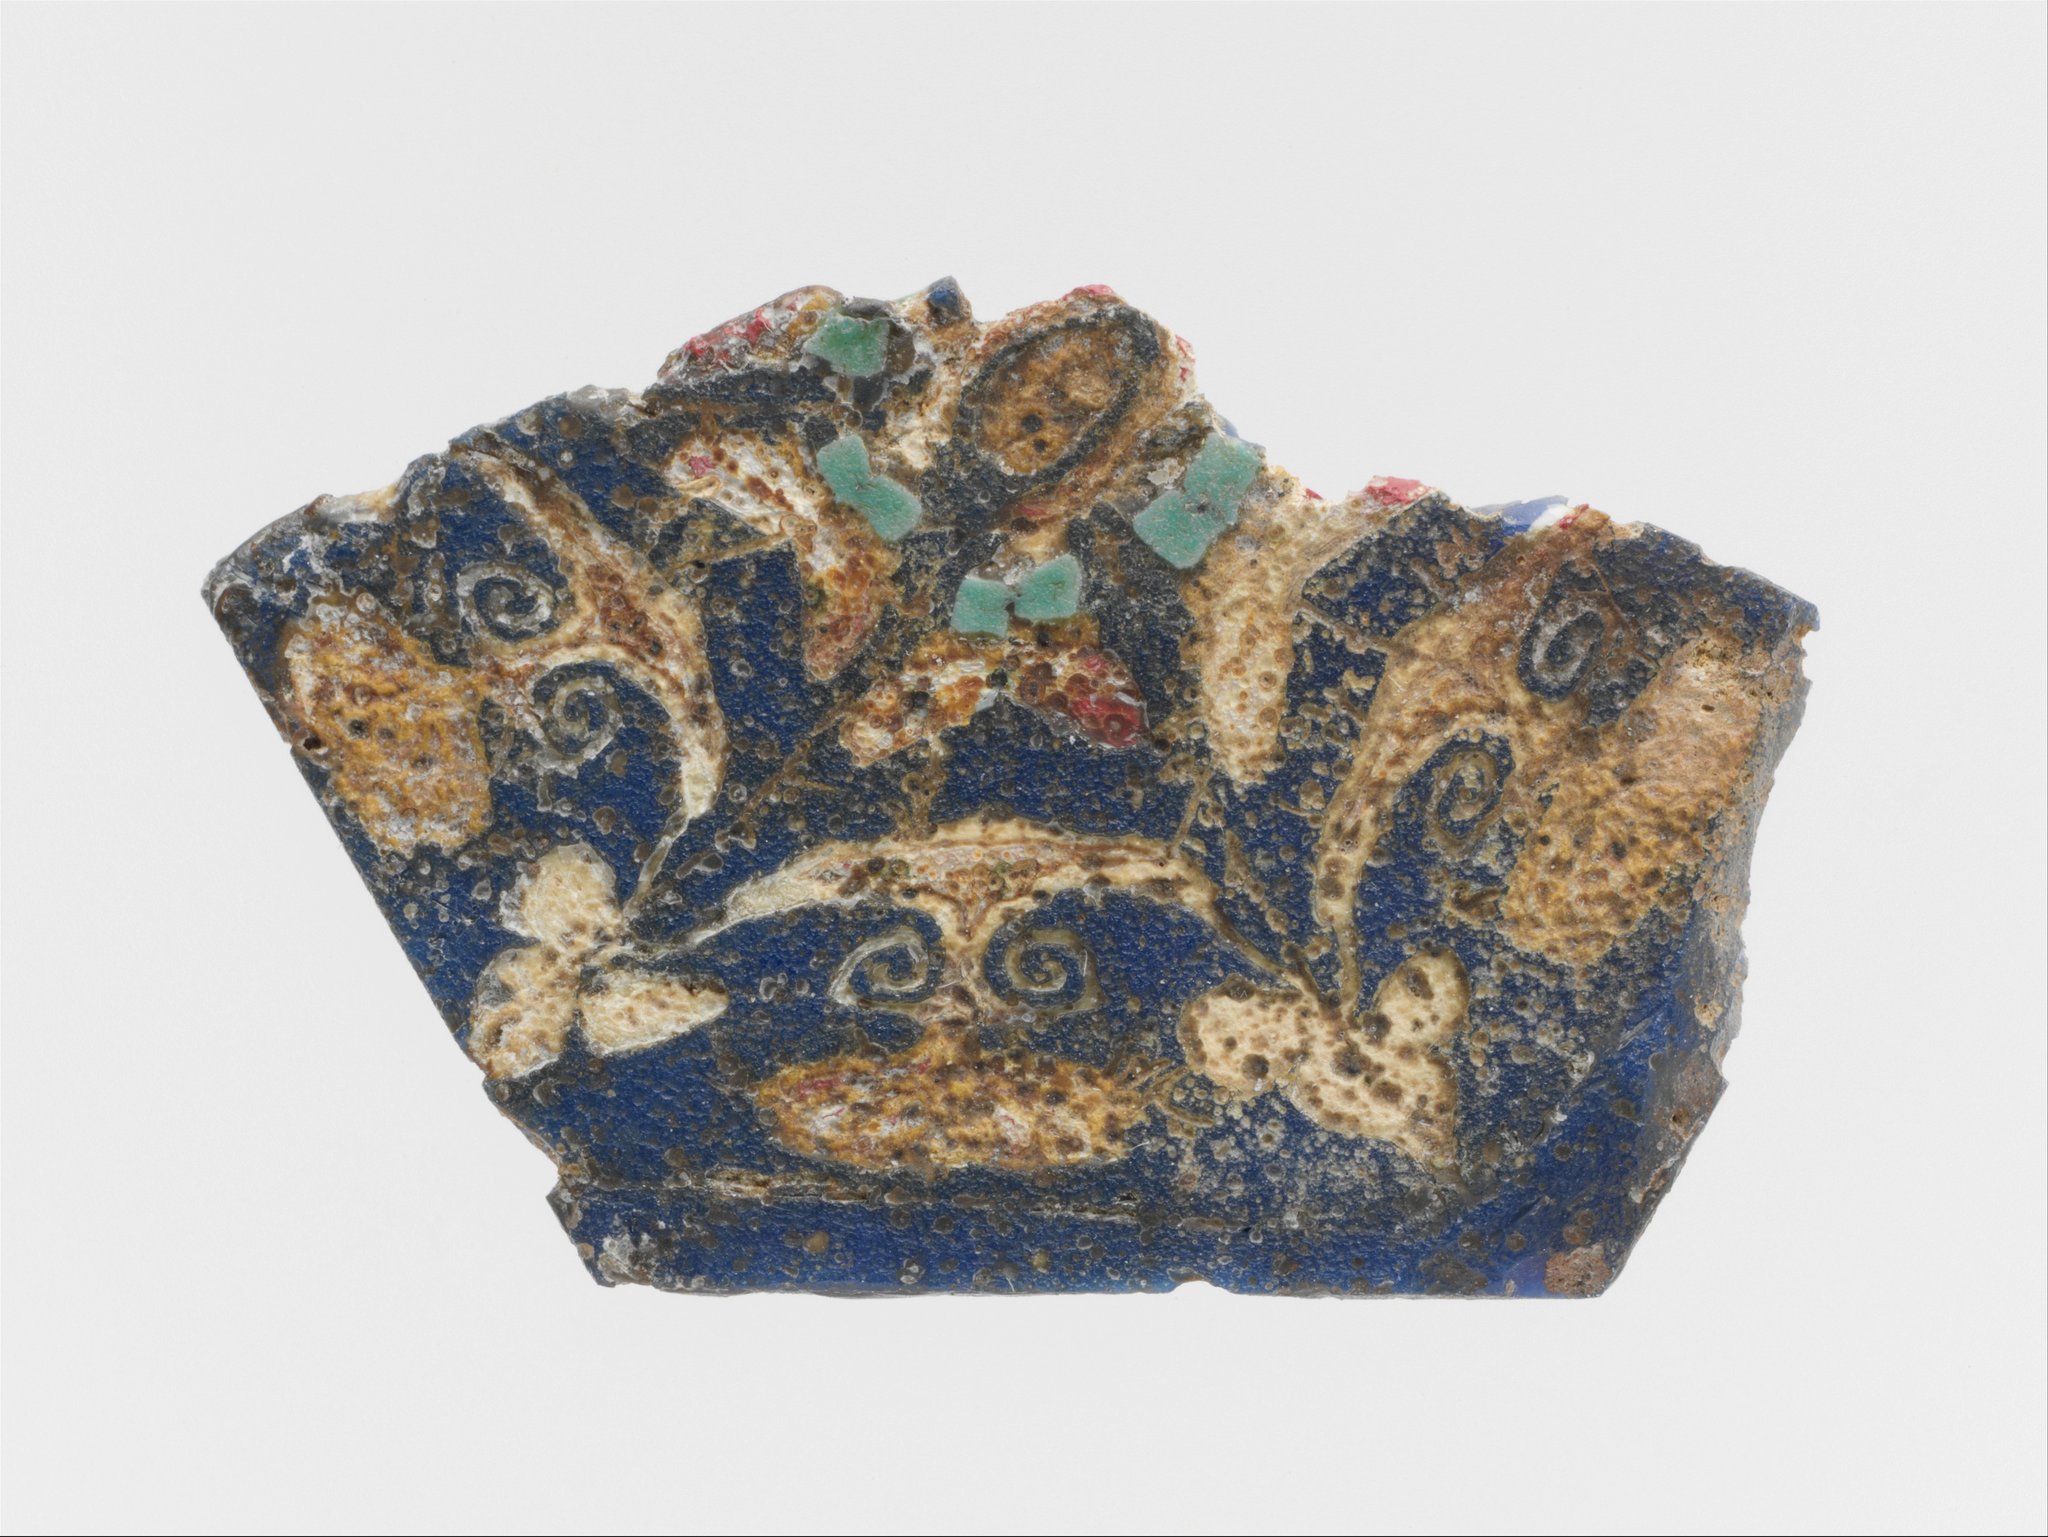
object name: mosaic block inlay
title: Glass mosaic inlay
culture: egyptian or roman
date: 100 BCE-100 CE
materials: glass